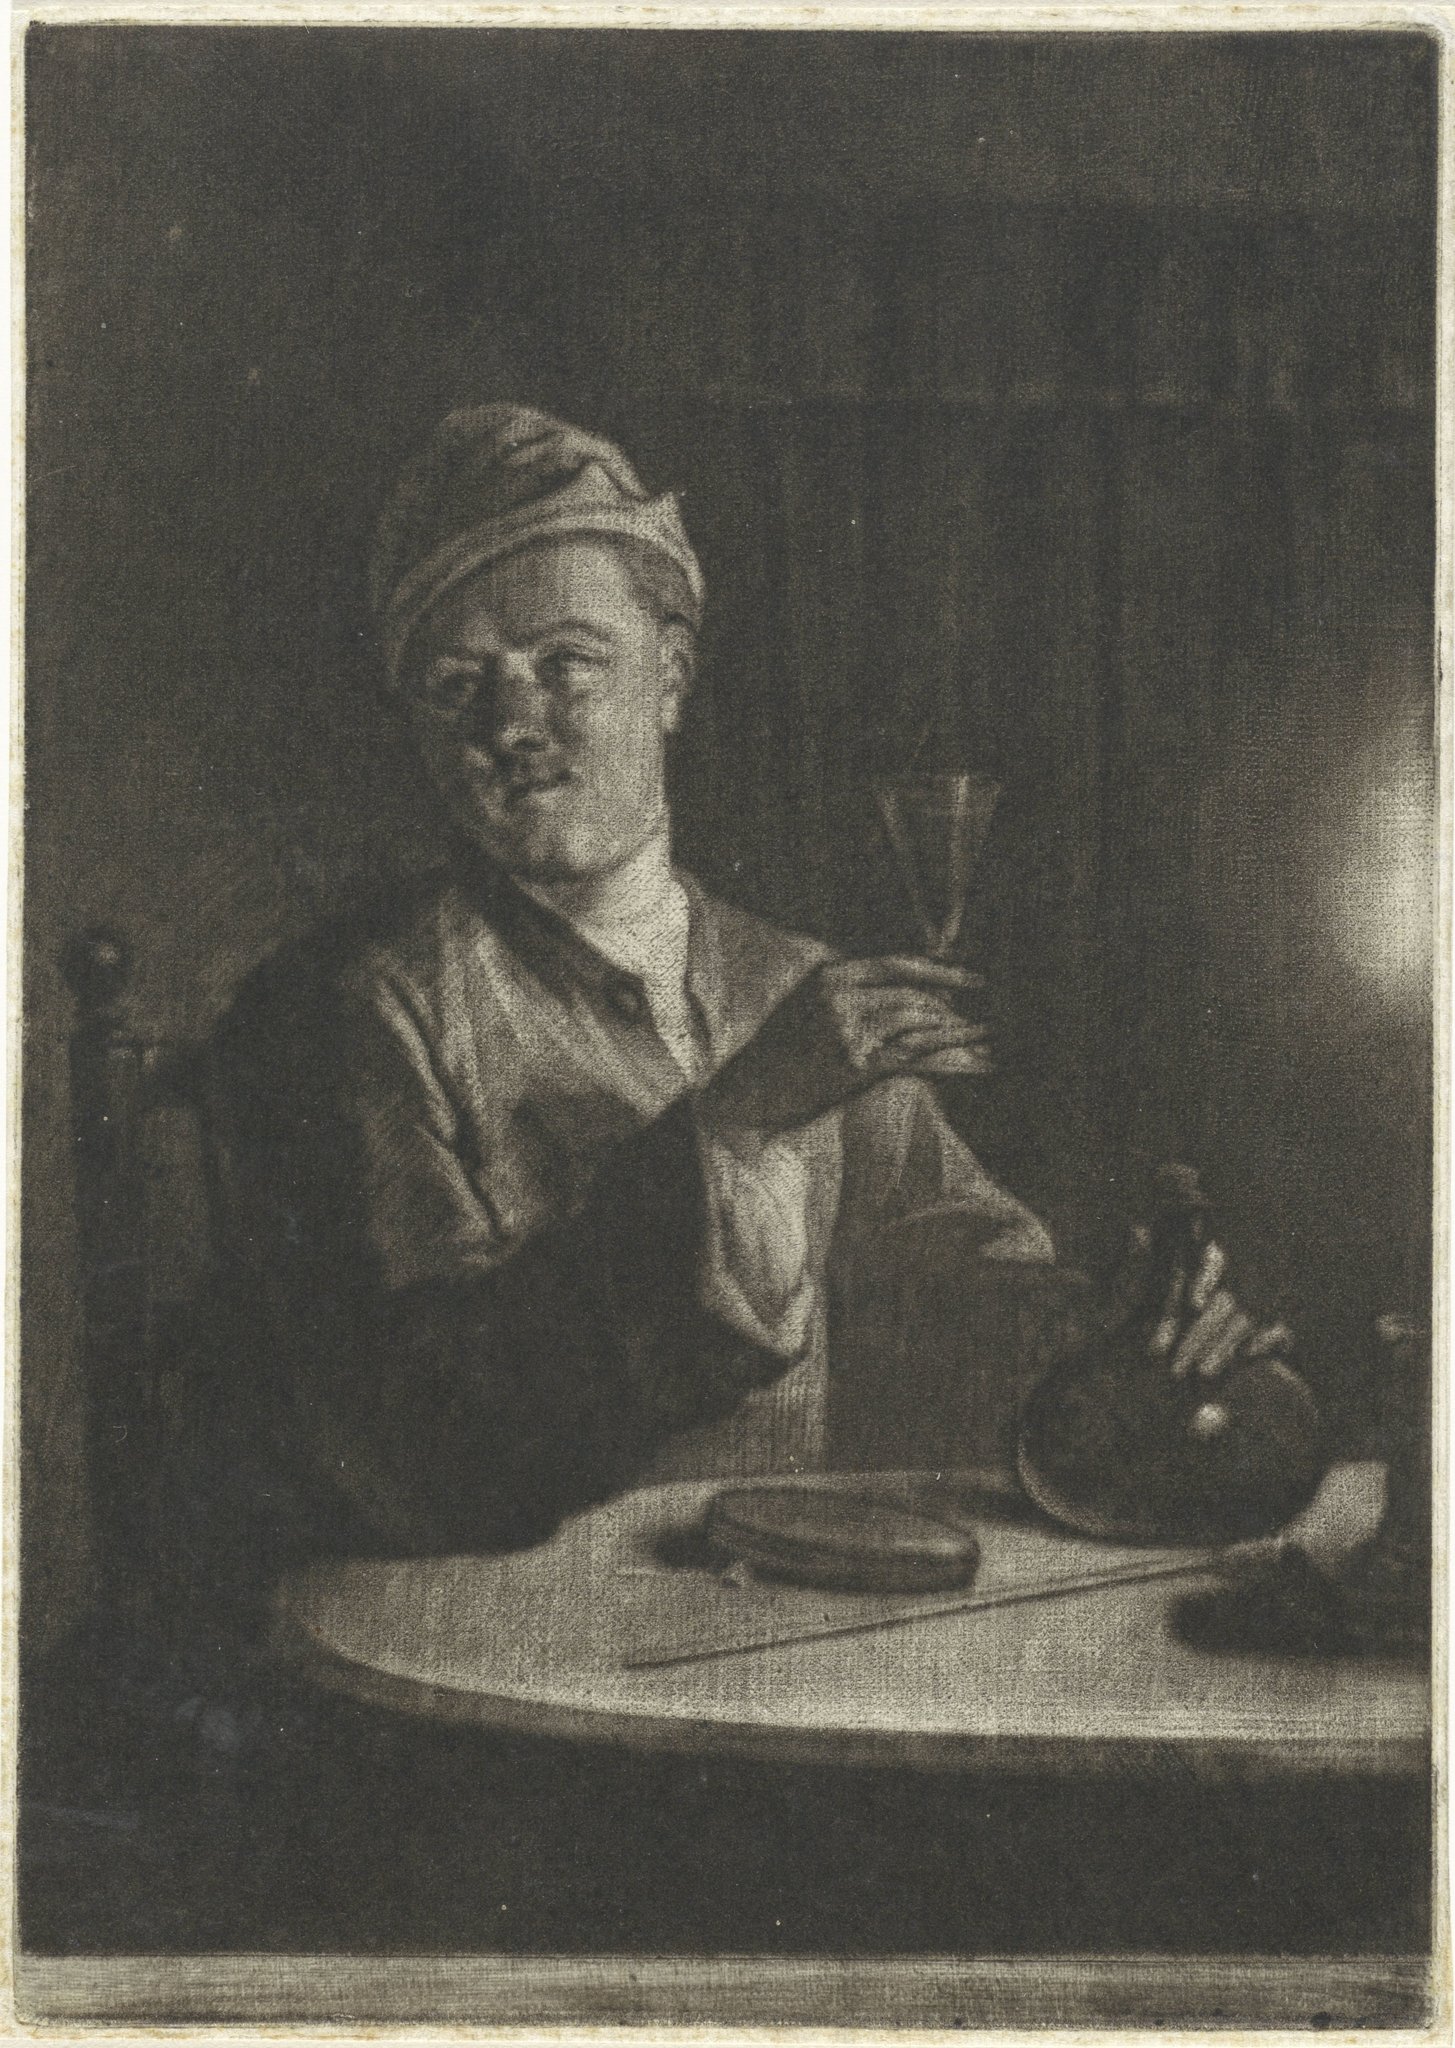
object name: print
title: Man met opgeheven glas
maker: aert schouman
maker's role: draughtsman, painter, print maker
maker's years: 1710-1792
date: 1720-1792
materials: paper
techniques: mezzotint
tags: pipe ~ tobacco, candle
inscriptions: collector's mark: Lugt 2228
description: Een man heft zijn glas, bij kaarslicht. Hij zit aan een tafel waarop een drankkruik en een pijp liggen.